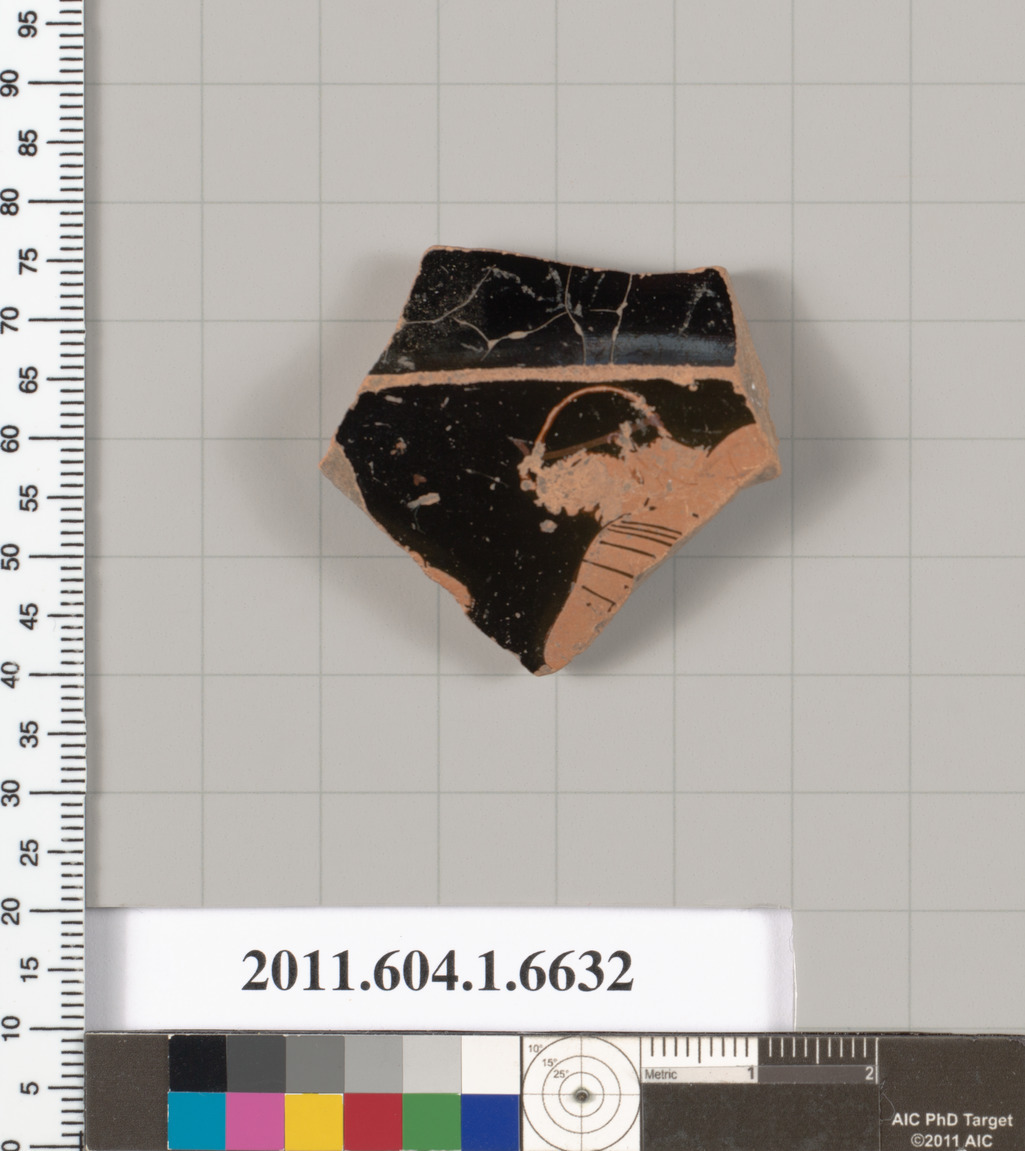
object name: kylix fragment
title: Terracotta fragment of a kylix (drinking cup)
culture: greek, attic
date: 490-470 BCE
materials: terracotta